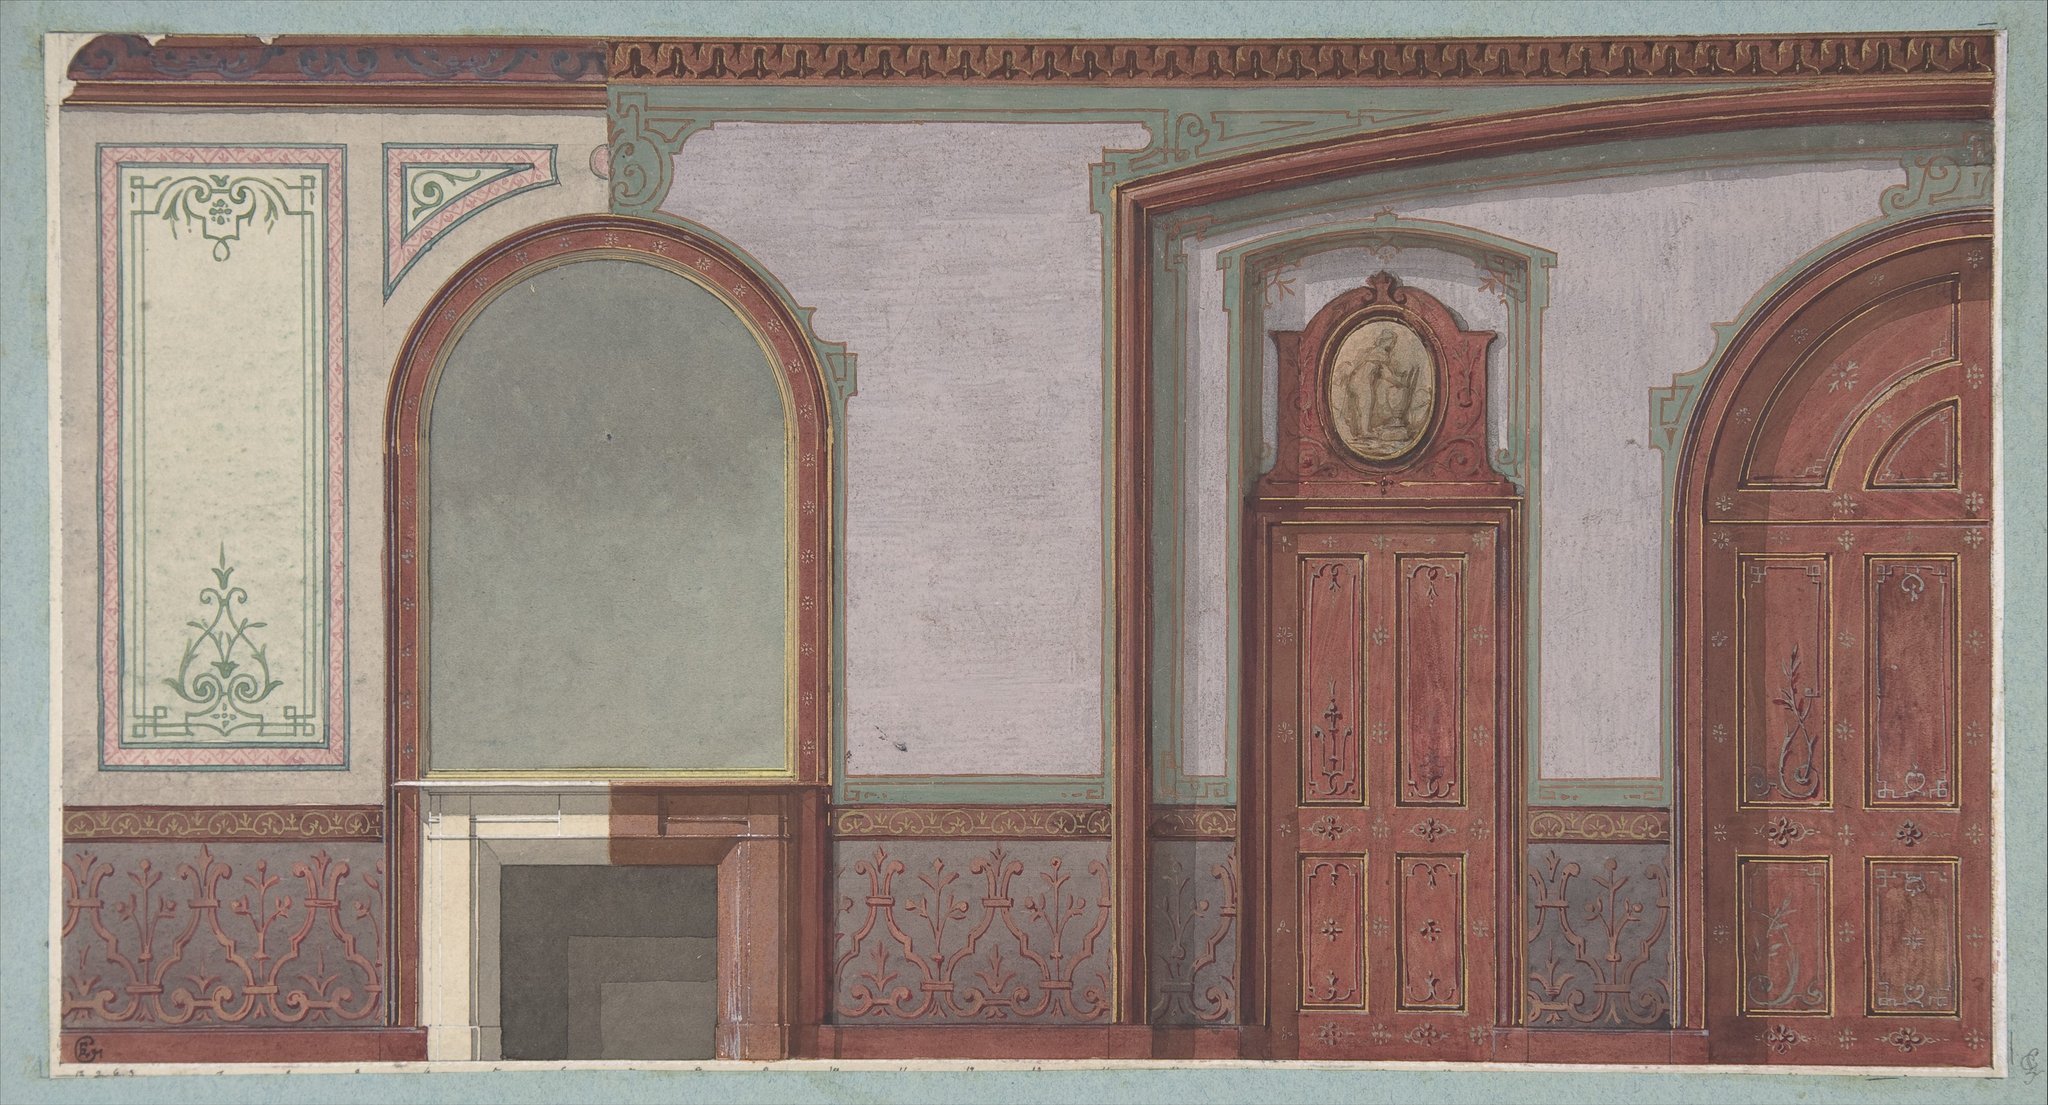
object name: drawing ornament architecture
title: Design for Painted Wall Paneling, Deepdene, Dorking, Surrey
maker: jules-edmond-charles lachaise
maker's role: artist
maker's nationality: french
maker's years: 1897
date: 1875-1879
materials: gouache, watercolor